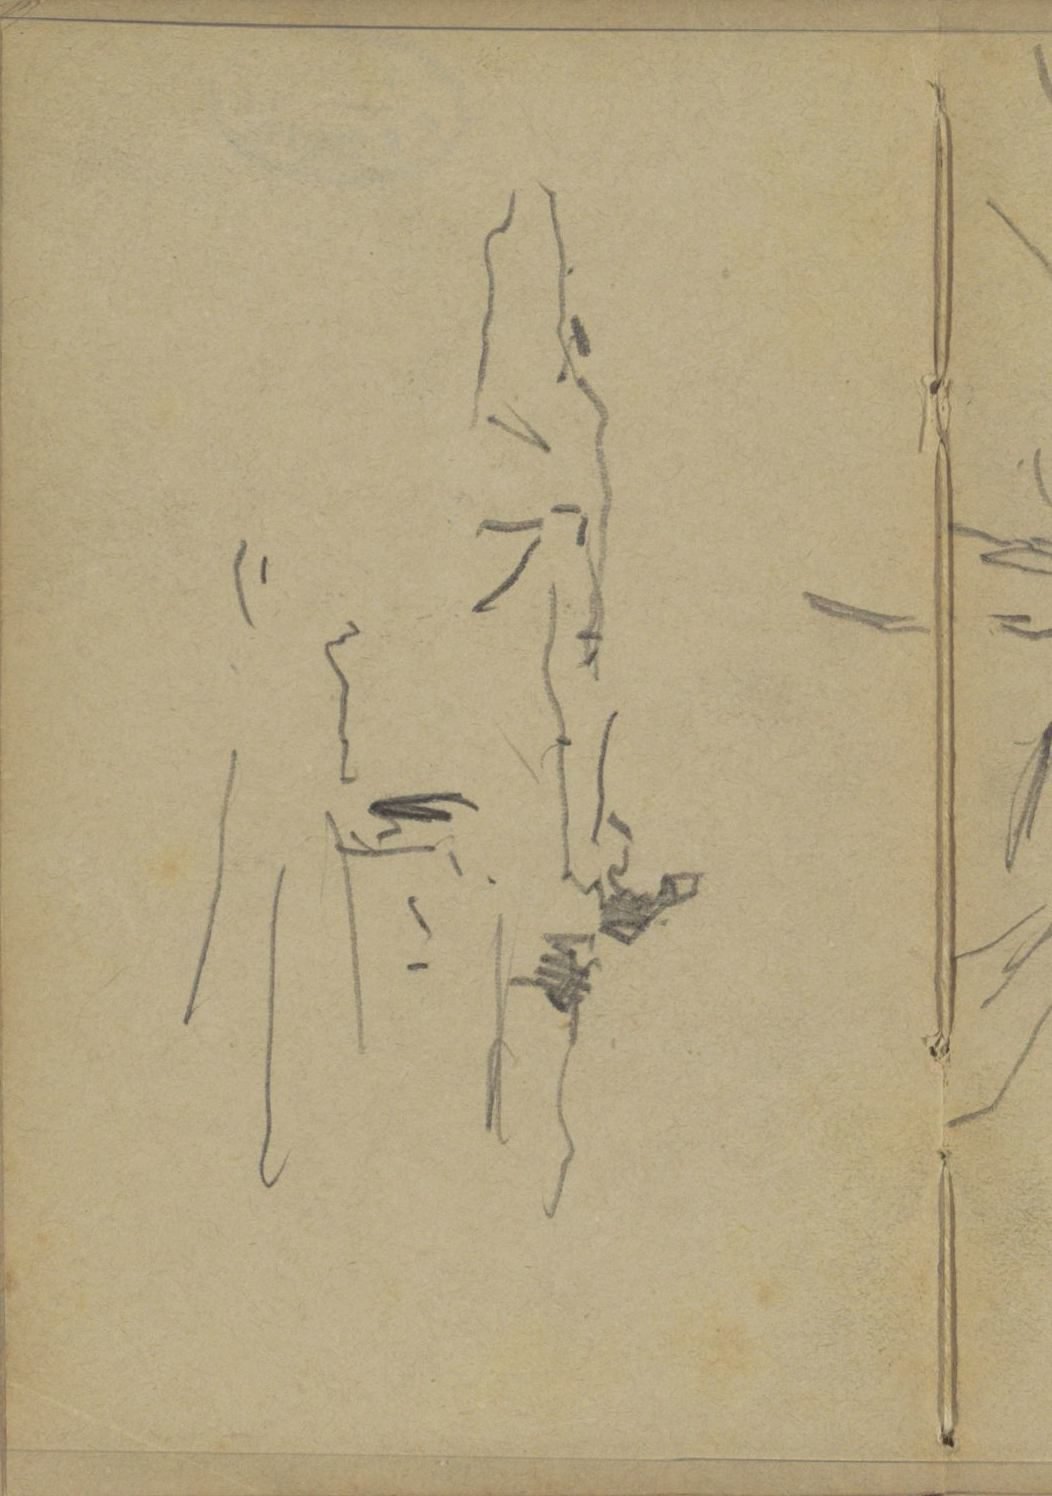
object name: sketchbook leaf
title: Soldaten in een landschap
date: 1887-1891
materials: paper, pencil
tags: landscapes, division of armed forces (+ infantry)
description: Pagina 125 uit een schetsboek met 83 bladen.